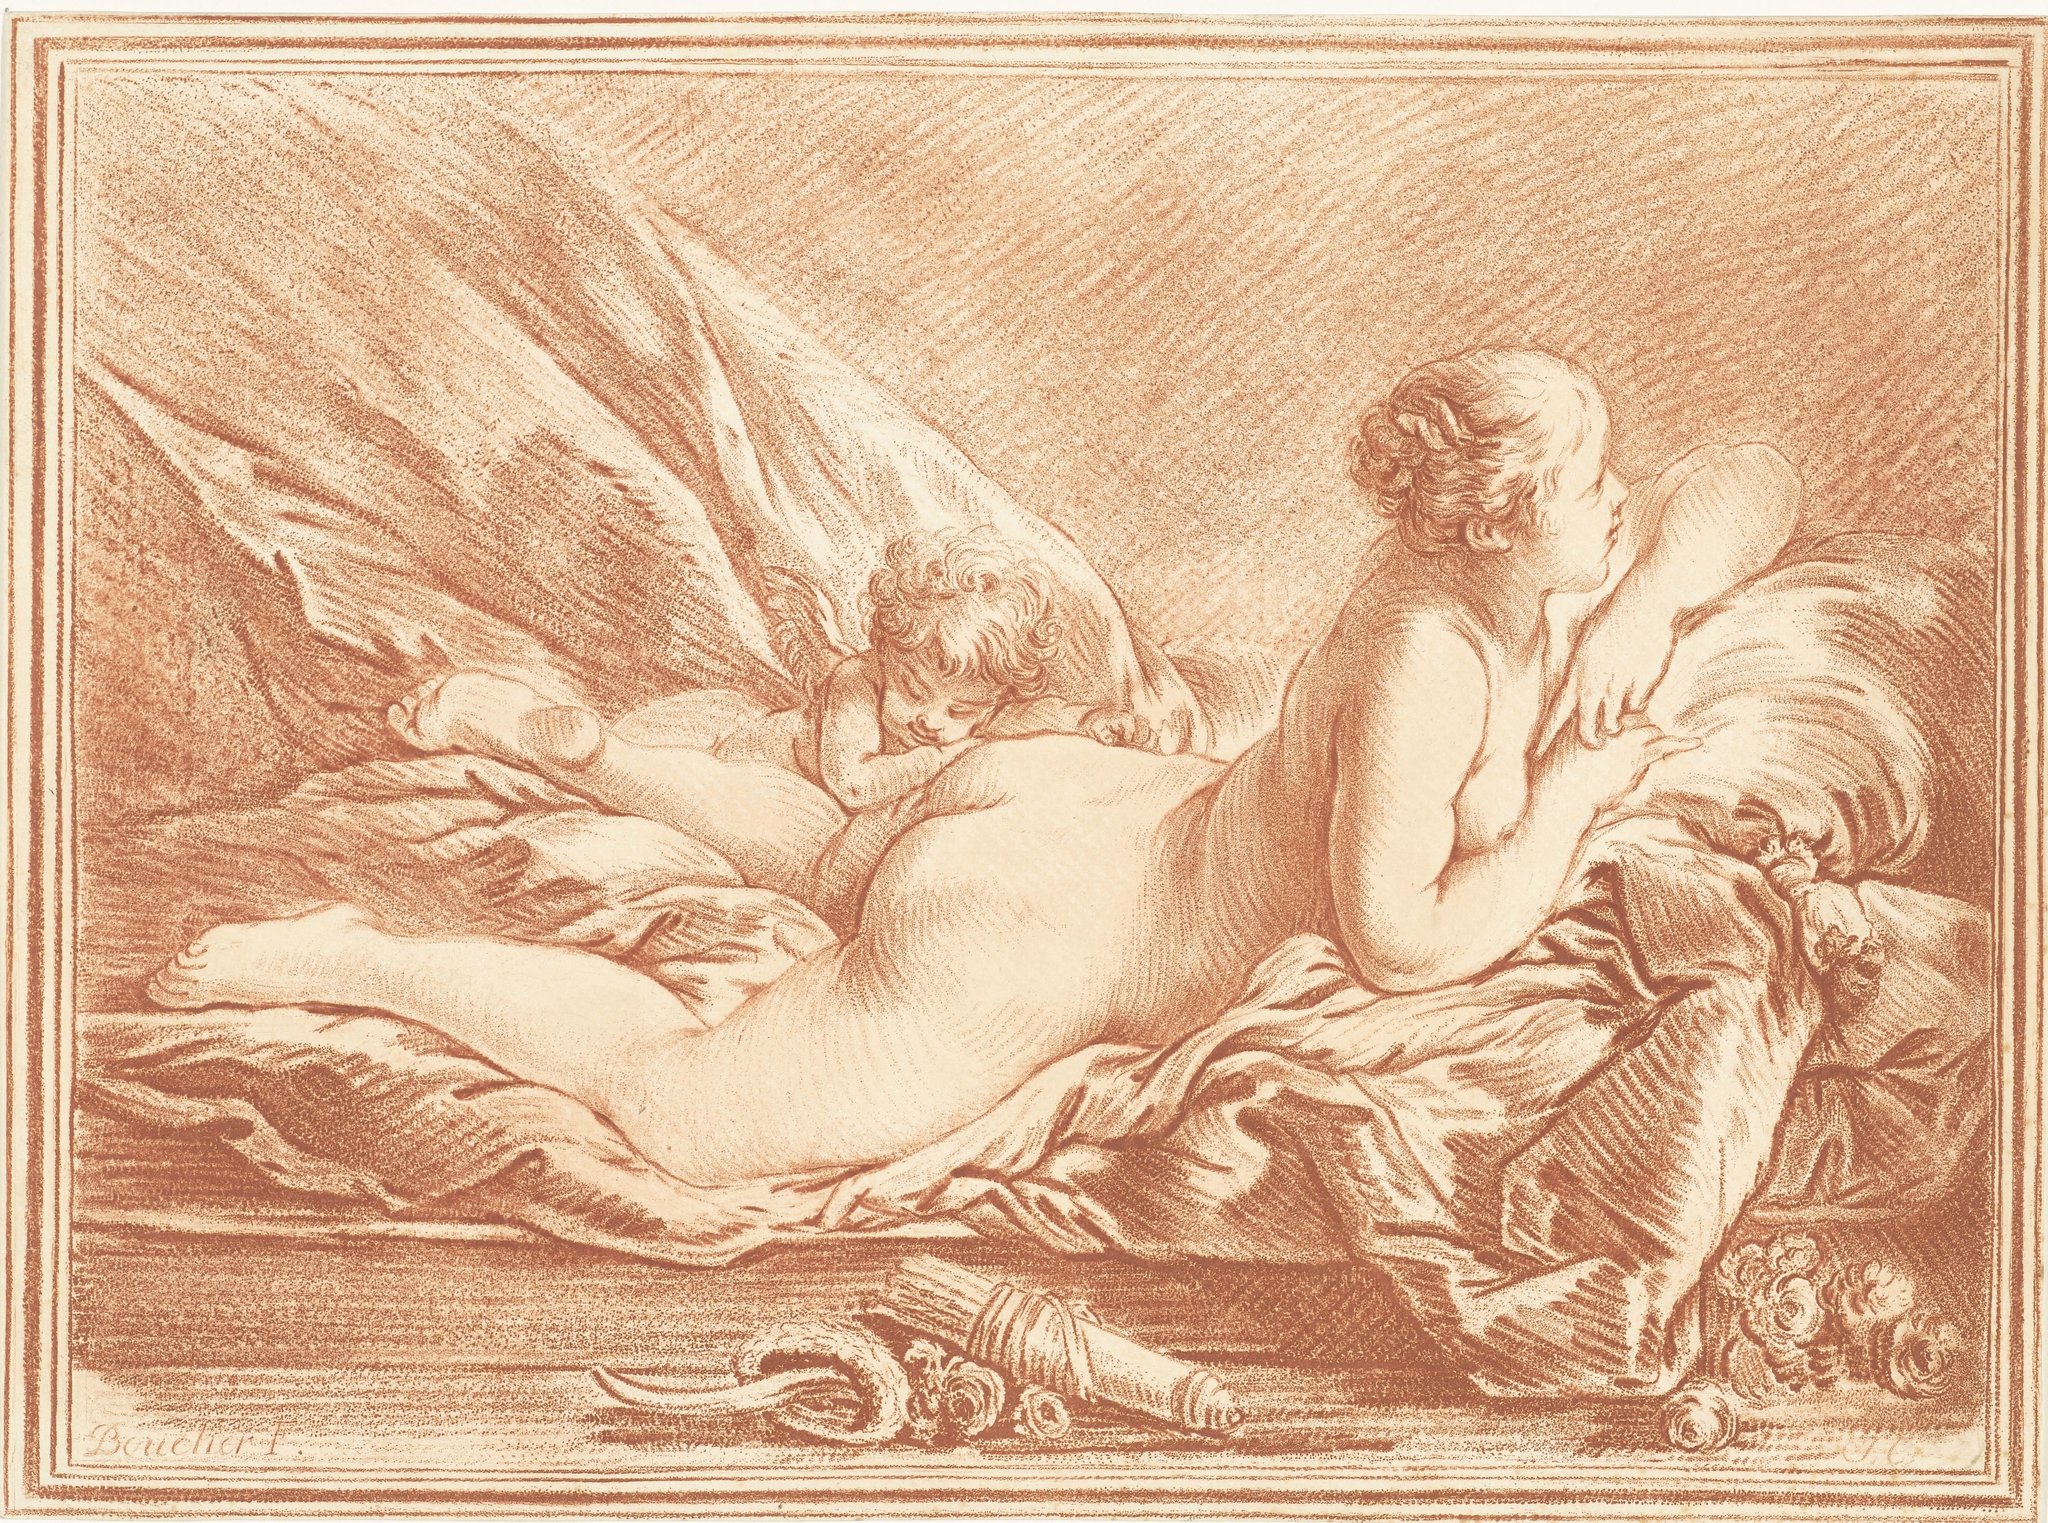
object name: print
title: Venus en cupido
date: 1724-1798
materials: paper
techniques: printmaking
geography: paris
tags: couch, sofa, settee, venus and cupid (cupid not being mere attribute)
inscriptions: collector's mark: Lugt 240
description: Venus ligt naakt op een bed. Cupido ligt naast haar te slapen. Zijn pijl en boog liggen naast het bed.